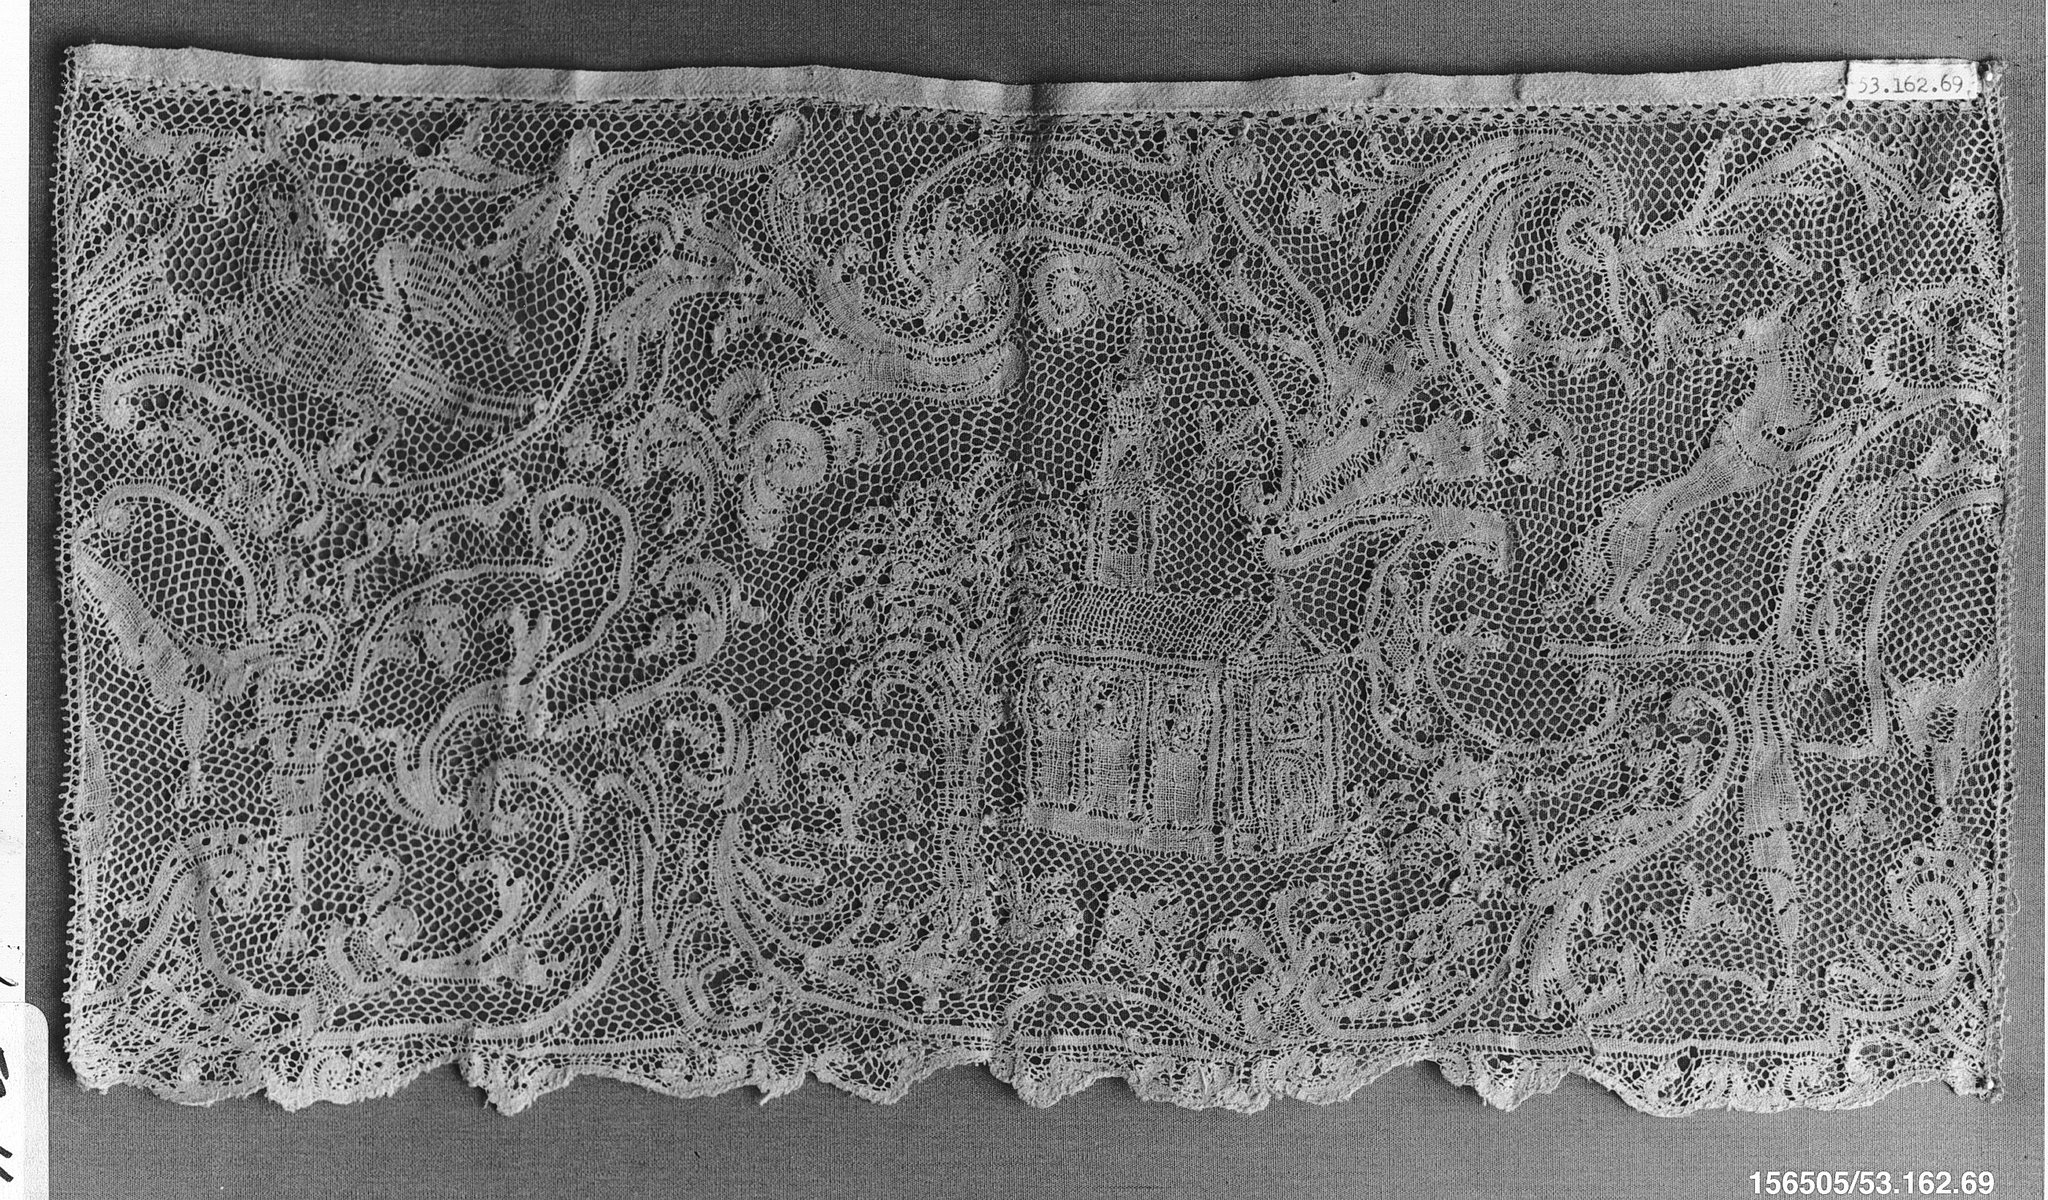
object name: border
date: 1701-1800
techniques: lace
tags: animals,birds,houses